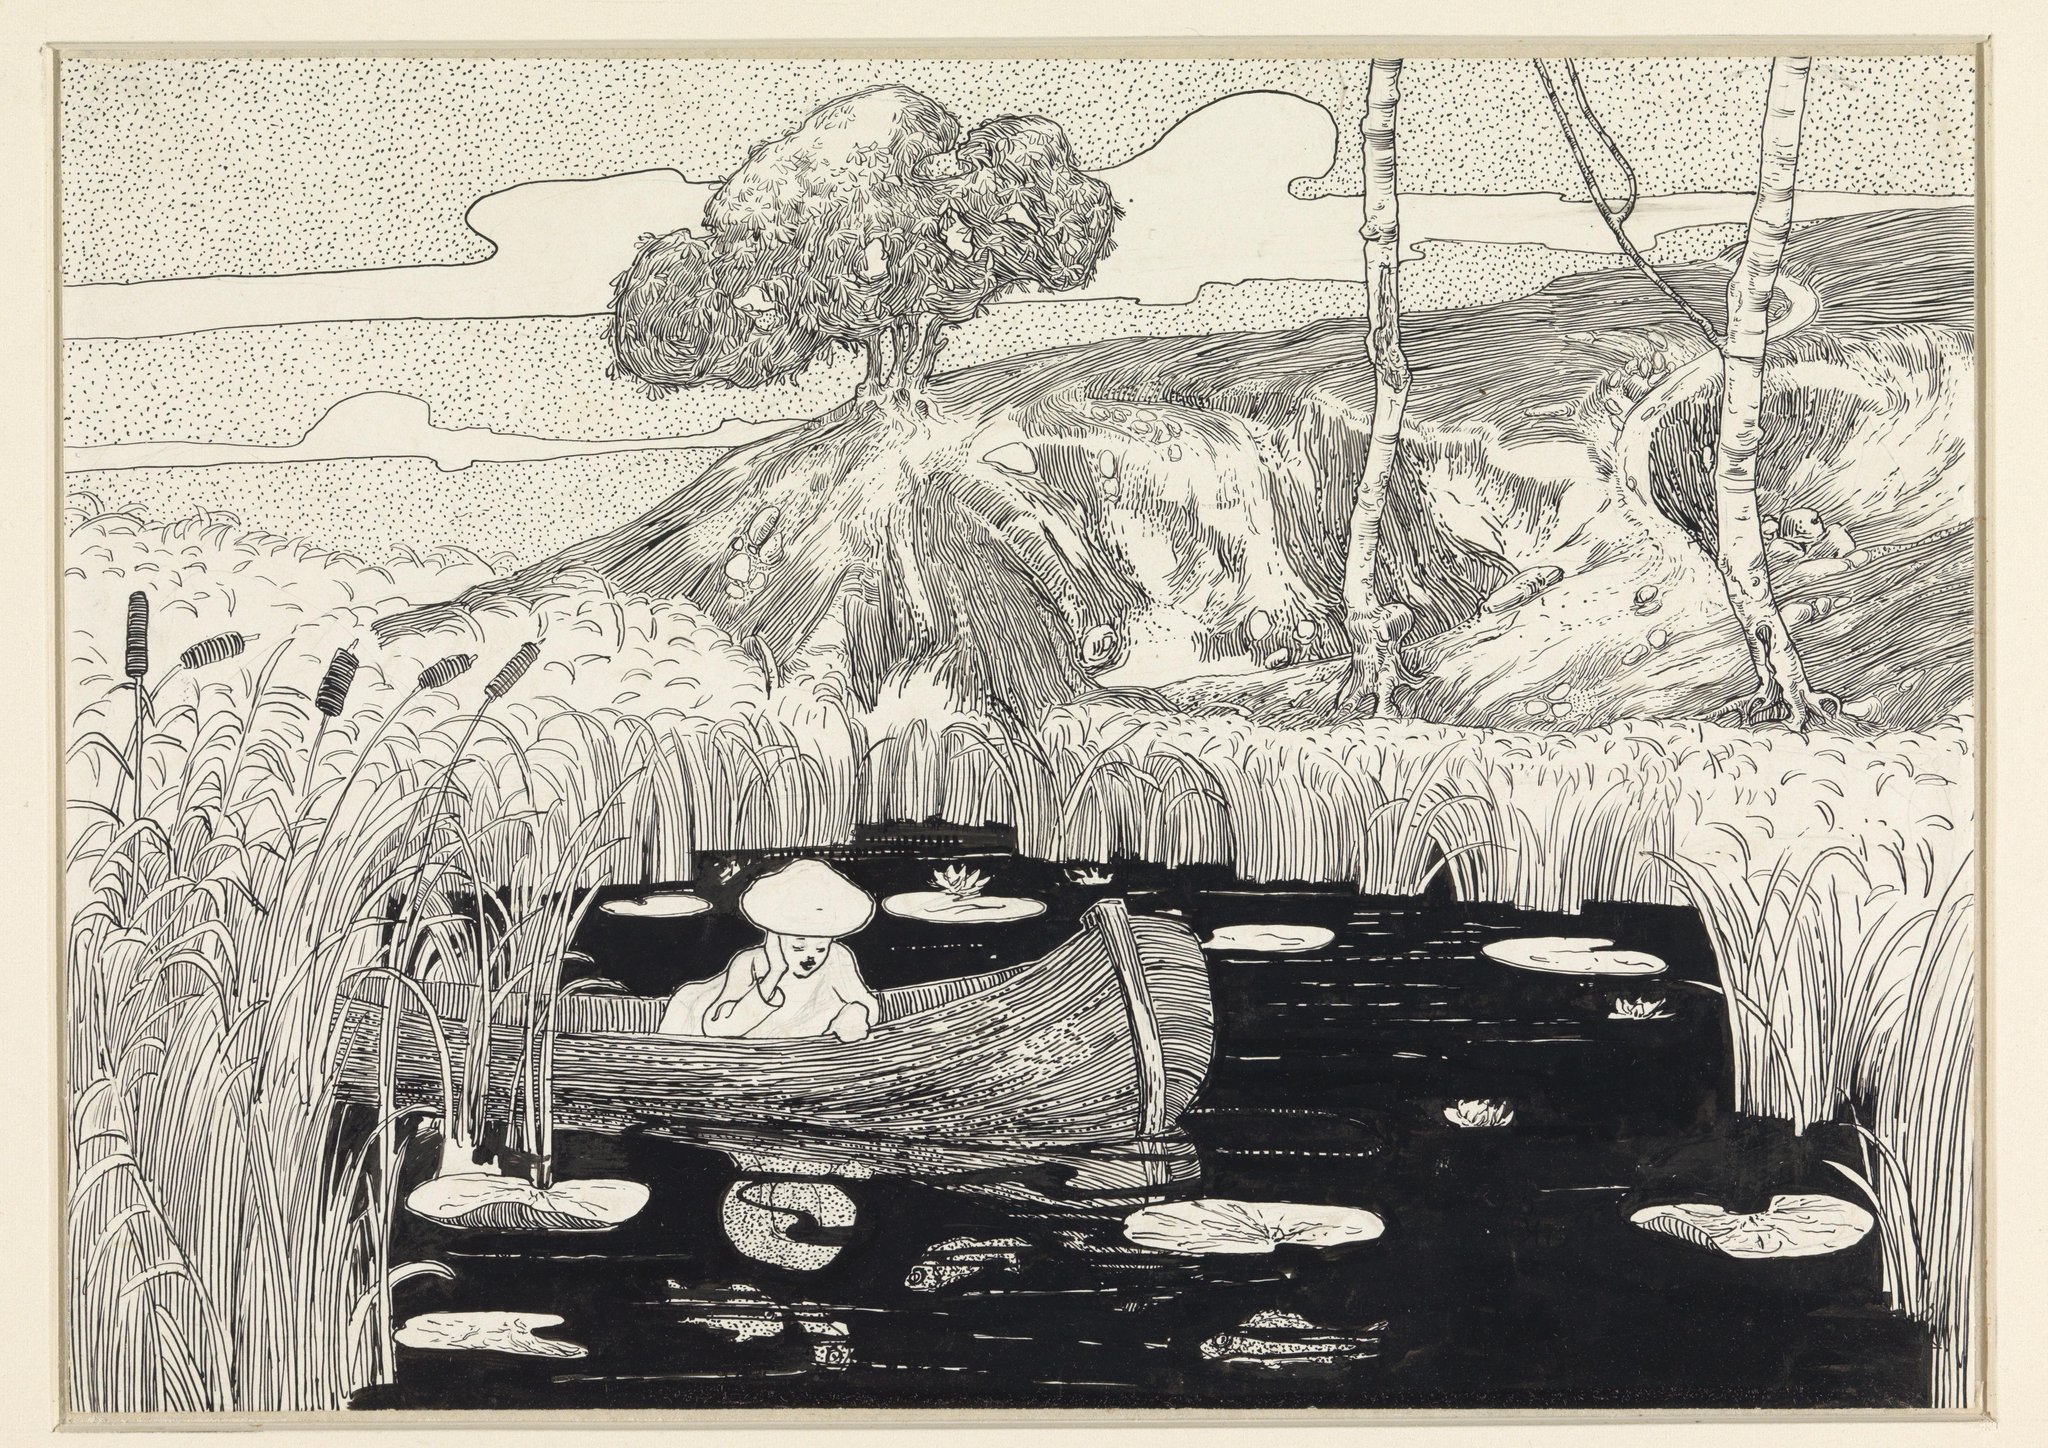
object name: drawing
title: Persoon in boot starend in het water van een vijver met waterlelies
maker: c. lapine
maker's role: draughtsman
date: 1895-1900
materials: ink, paper, pencil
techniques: brush, pen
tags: flowers: water-lily, lake